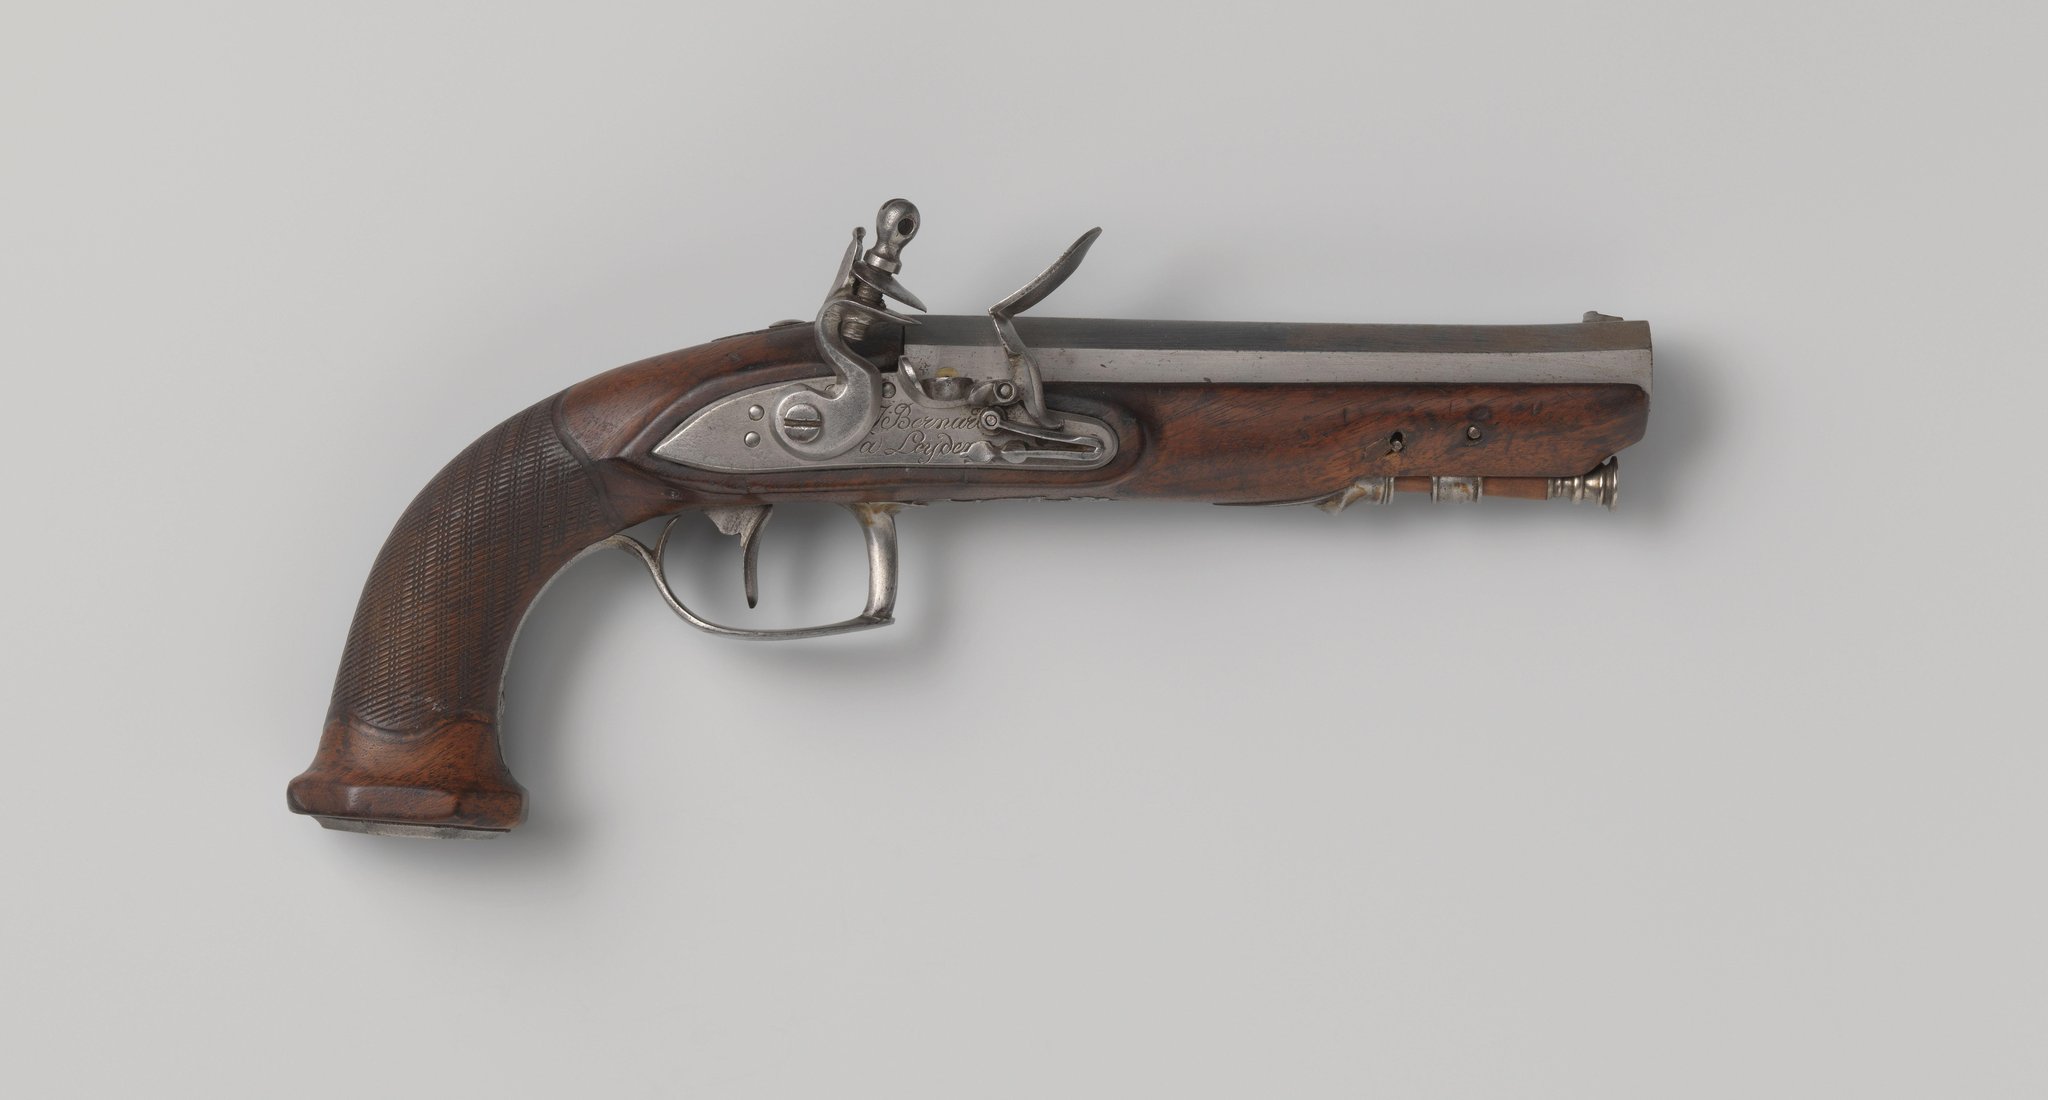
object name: flintlock pistol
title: Vuursteenpistool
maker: j. bernard (geweermaker)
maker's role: geweermaker, pistoolmaker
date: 1811-1813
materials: iron, wood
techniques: cutting, engraving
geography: leiden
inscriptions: mark: ‘E; E // LG’, signature: ‘J. Bernard // à Leyden’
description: Vuursteenpistool in empirestijl. Het slot is onversierd op een signatuur na. De loop is voorzien van een ijzeren vizierkorrel en onderop gemerkt met een verticale stang met een E, bovenop met ELG en een ster in een ovaal. De kolf is kruislings gegroefd en loopt uit in een platte, achthoekige kolfknop. Het ijzeren beslag bestaat onder meer uit een schroefplaat in de vorm van twee schroefplaatjes voor de slotbouten met een met lofwerk gegraveerd verlengstuk eraan vast, de aan de voorkant gehoekte en aan de achterkant gevorkte trekkerbeugel, en de achthoekige dekplaat onder de kolfkap gegraveerd met een achtbladige varen; de laadstok is voorzien van een ijzeren kap.